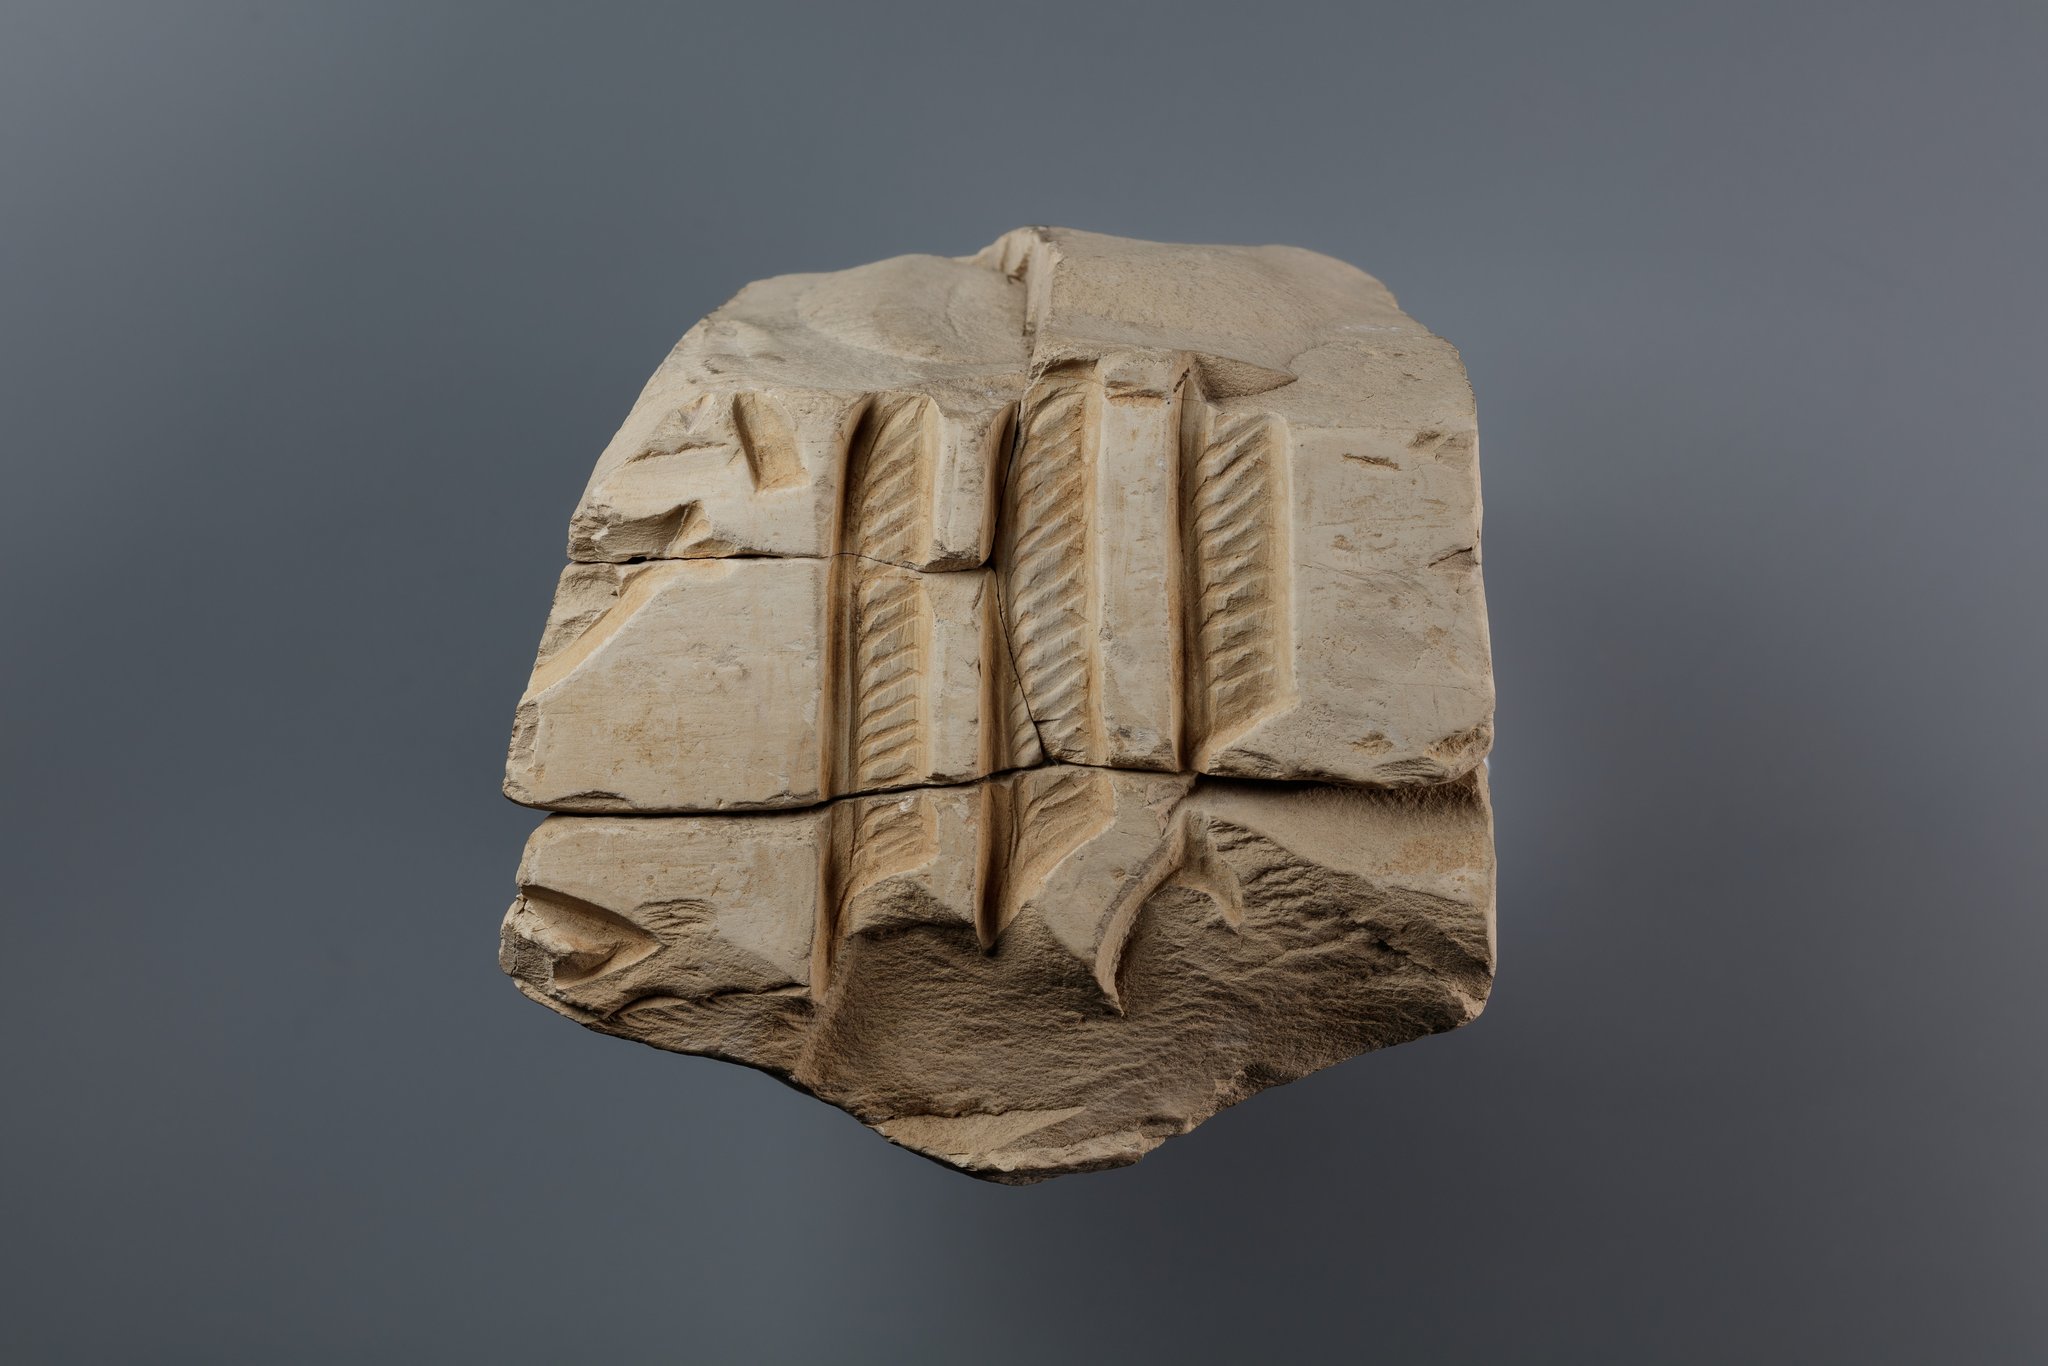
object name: relief fragment 47, tomb of mereri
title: Relief fragment possibly from the tomb of Mereri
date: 2100-2090 BCE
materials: stone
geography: egypt